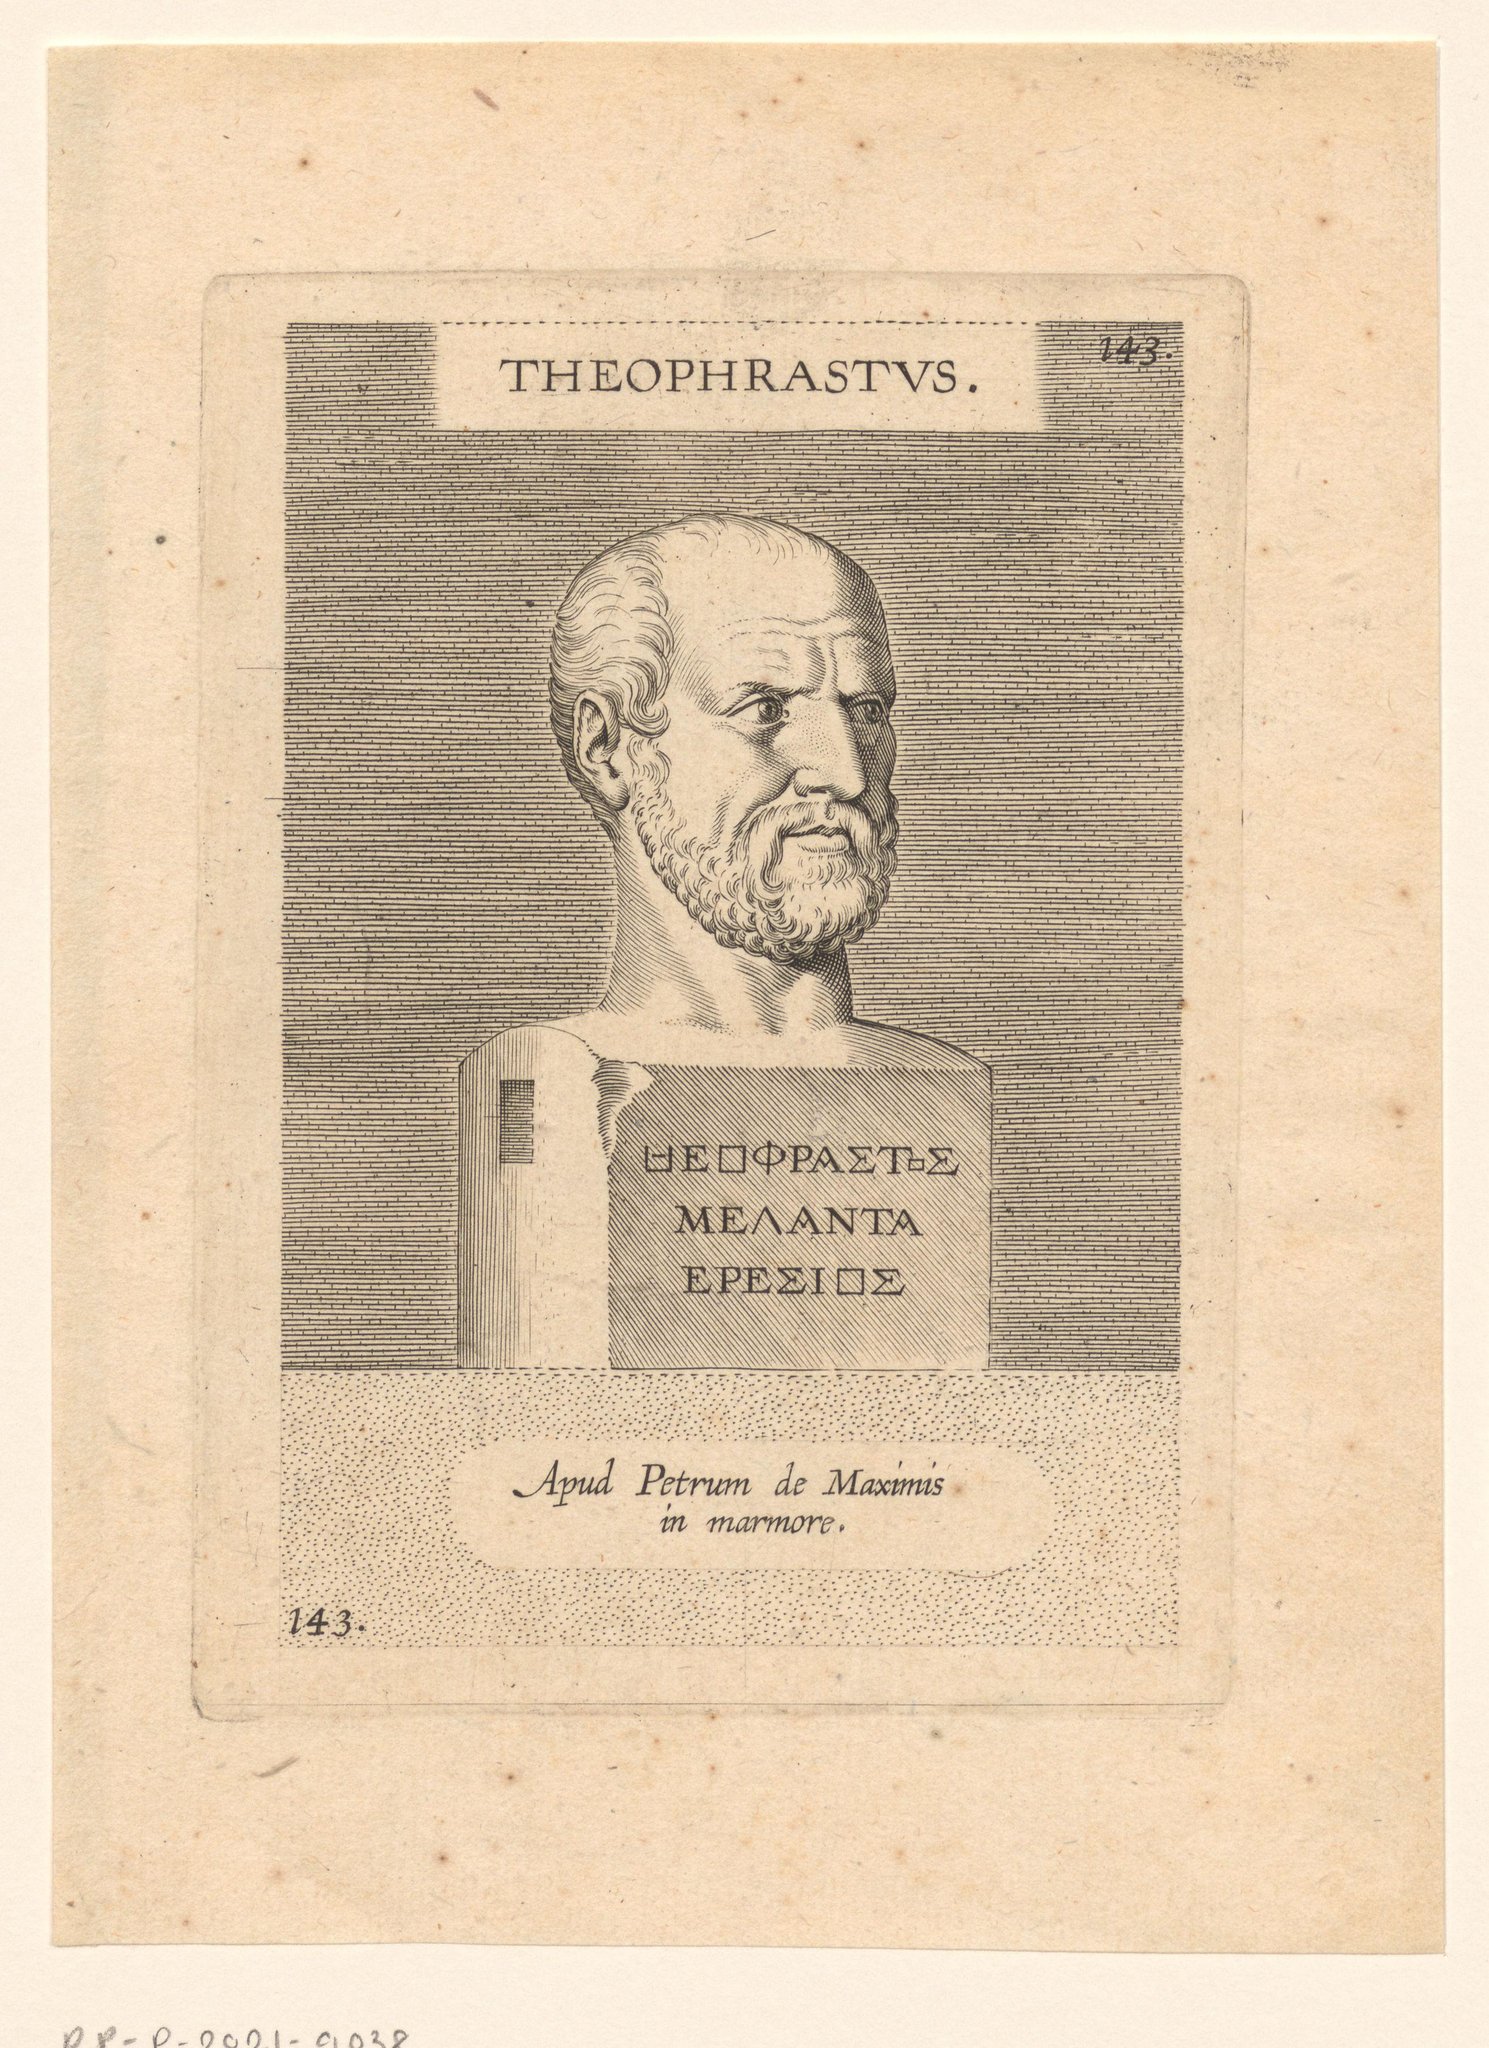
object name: print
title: Portret van Theophrastus van Eresus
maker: theodoor galle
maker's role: print maker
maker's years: 1571-1633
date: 1598-1606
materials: paper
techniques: engraving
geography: antwerp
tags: scholar, philosopher, historical persons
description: Prent gebruikt in: Orsini, Fulvio. Illustrium imagines ex antiquis marmoribus nomismatib[us] et gemmis expressae quae extant Romae. Antwerpen: Officina Plantiniana, 1598. Ook gebruikt in de 1606-editie van dit werk.